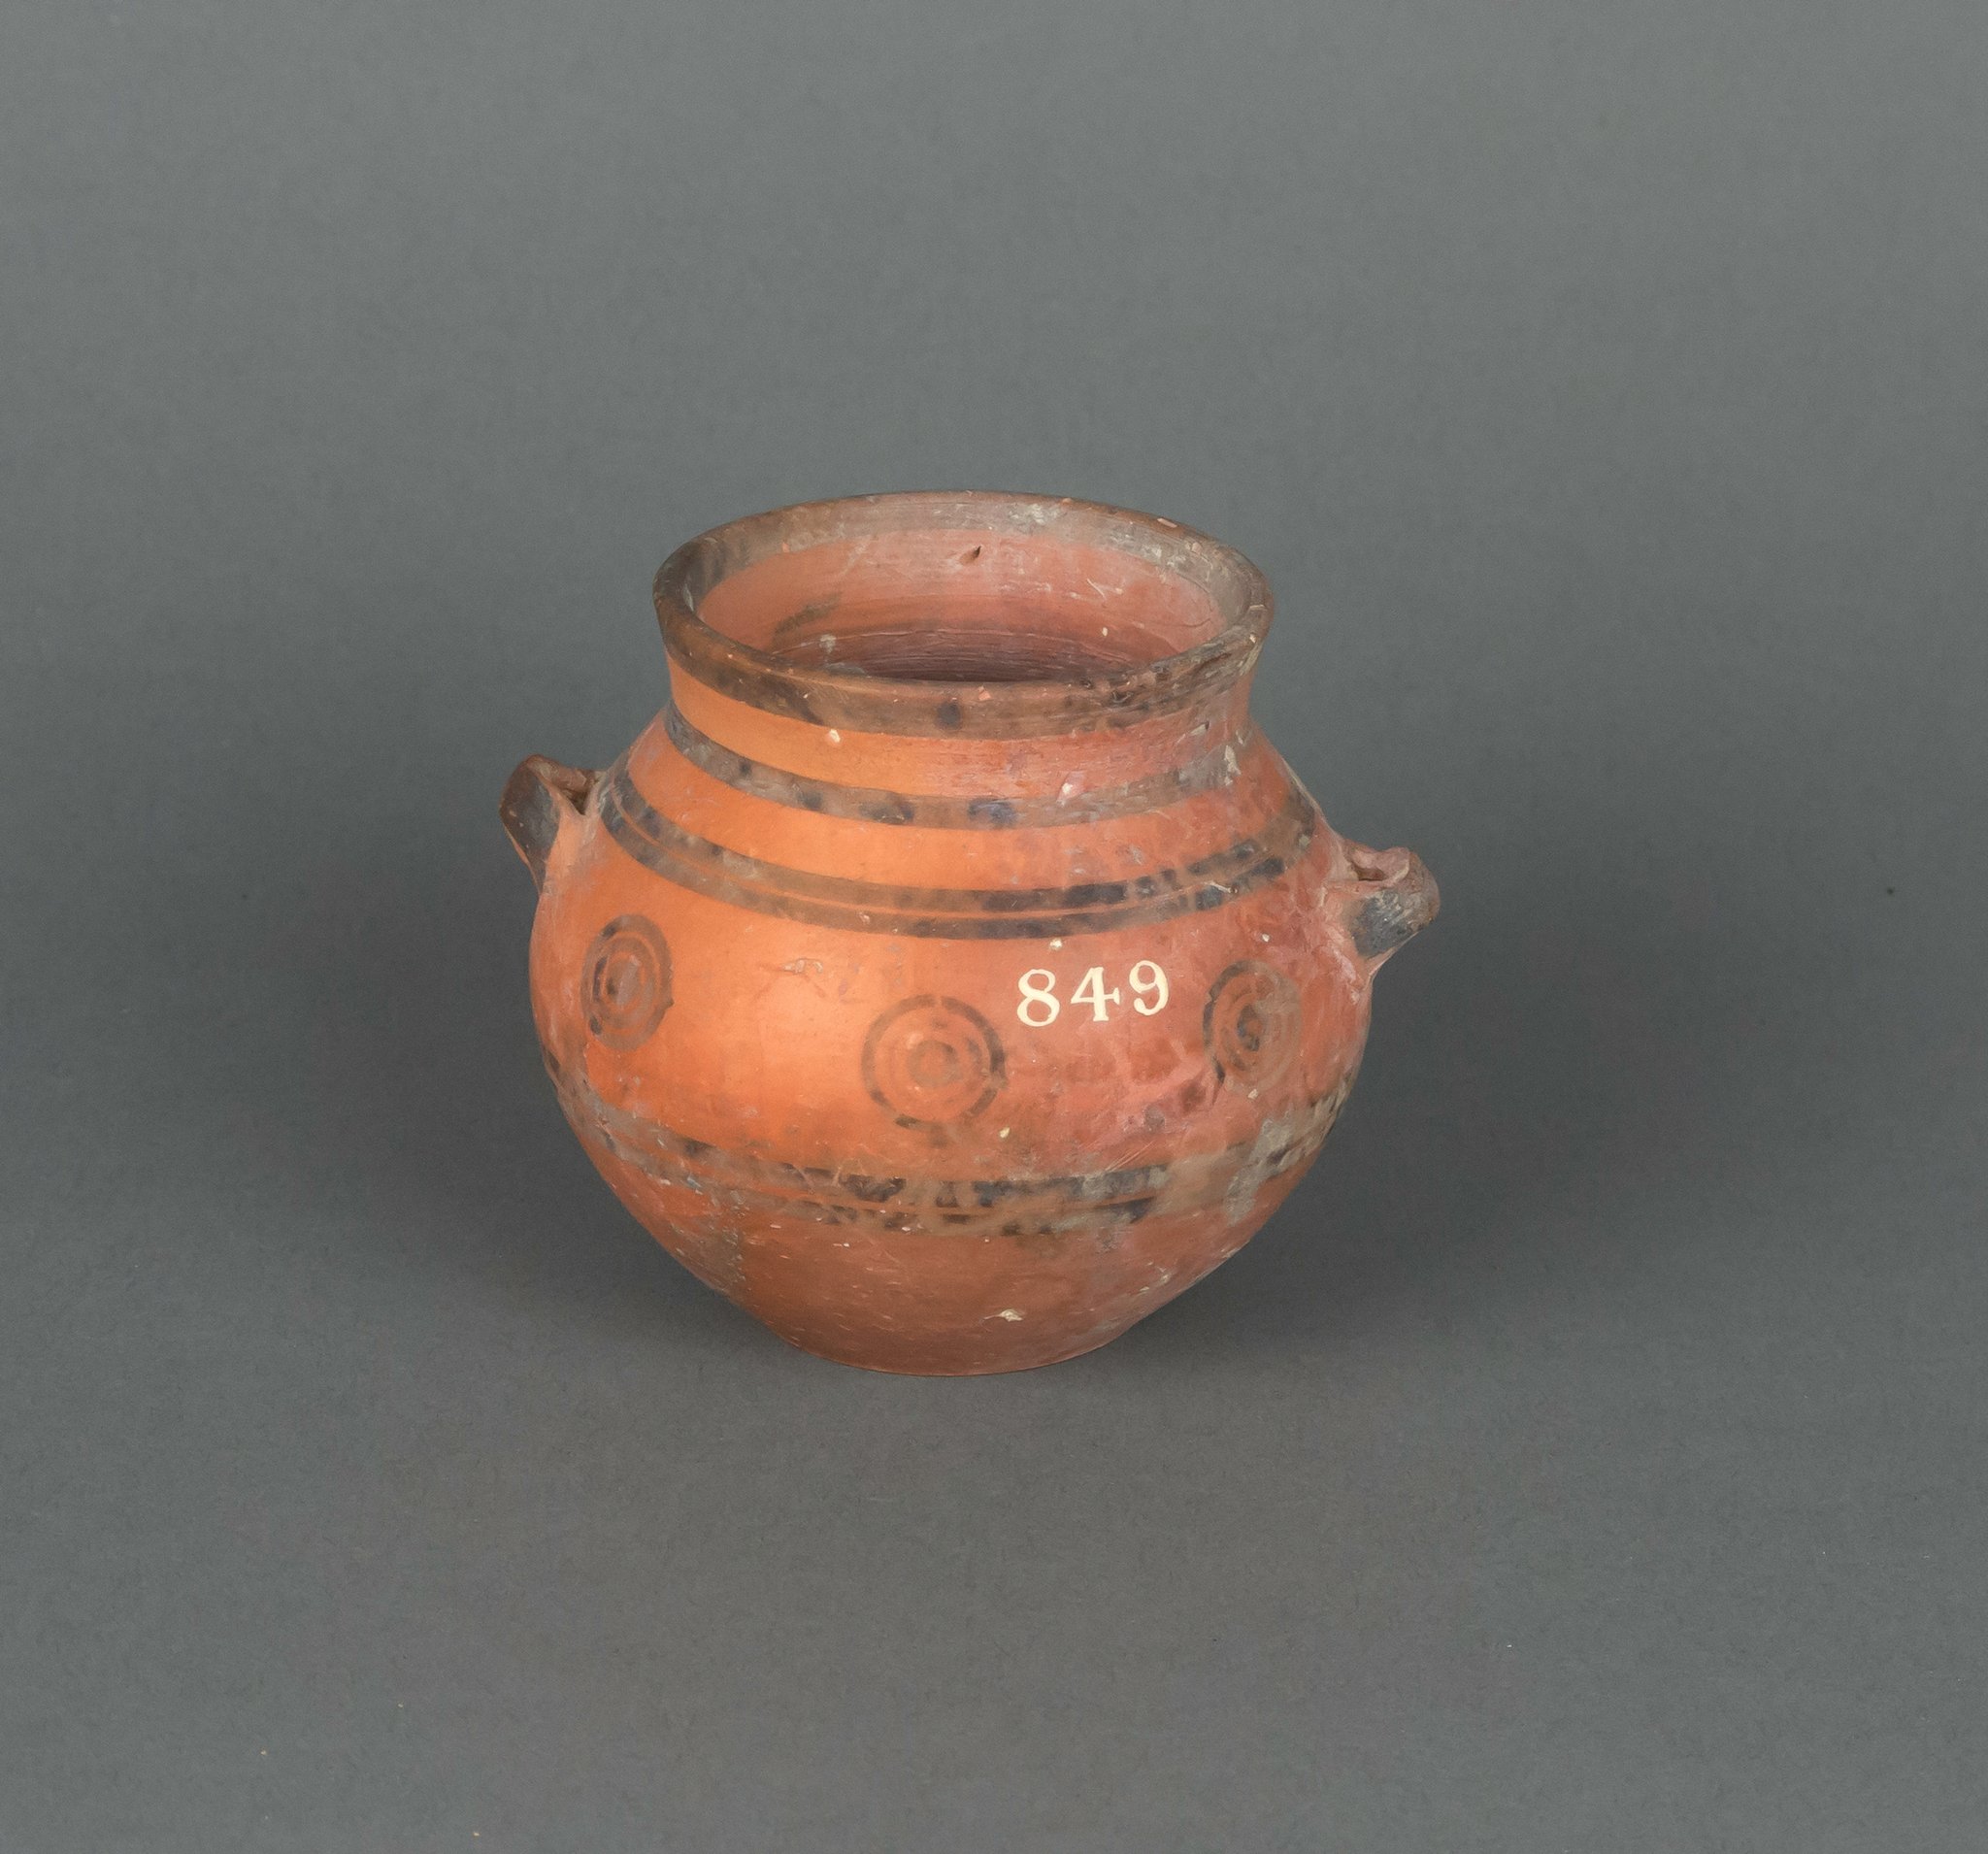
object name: amphoriskos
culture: cypriot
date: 750-600 BCE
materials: terracotta